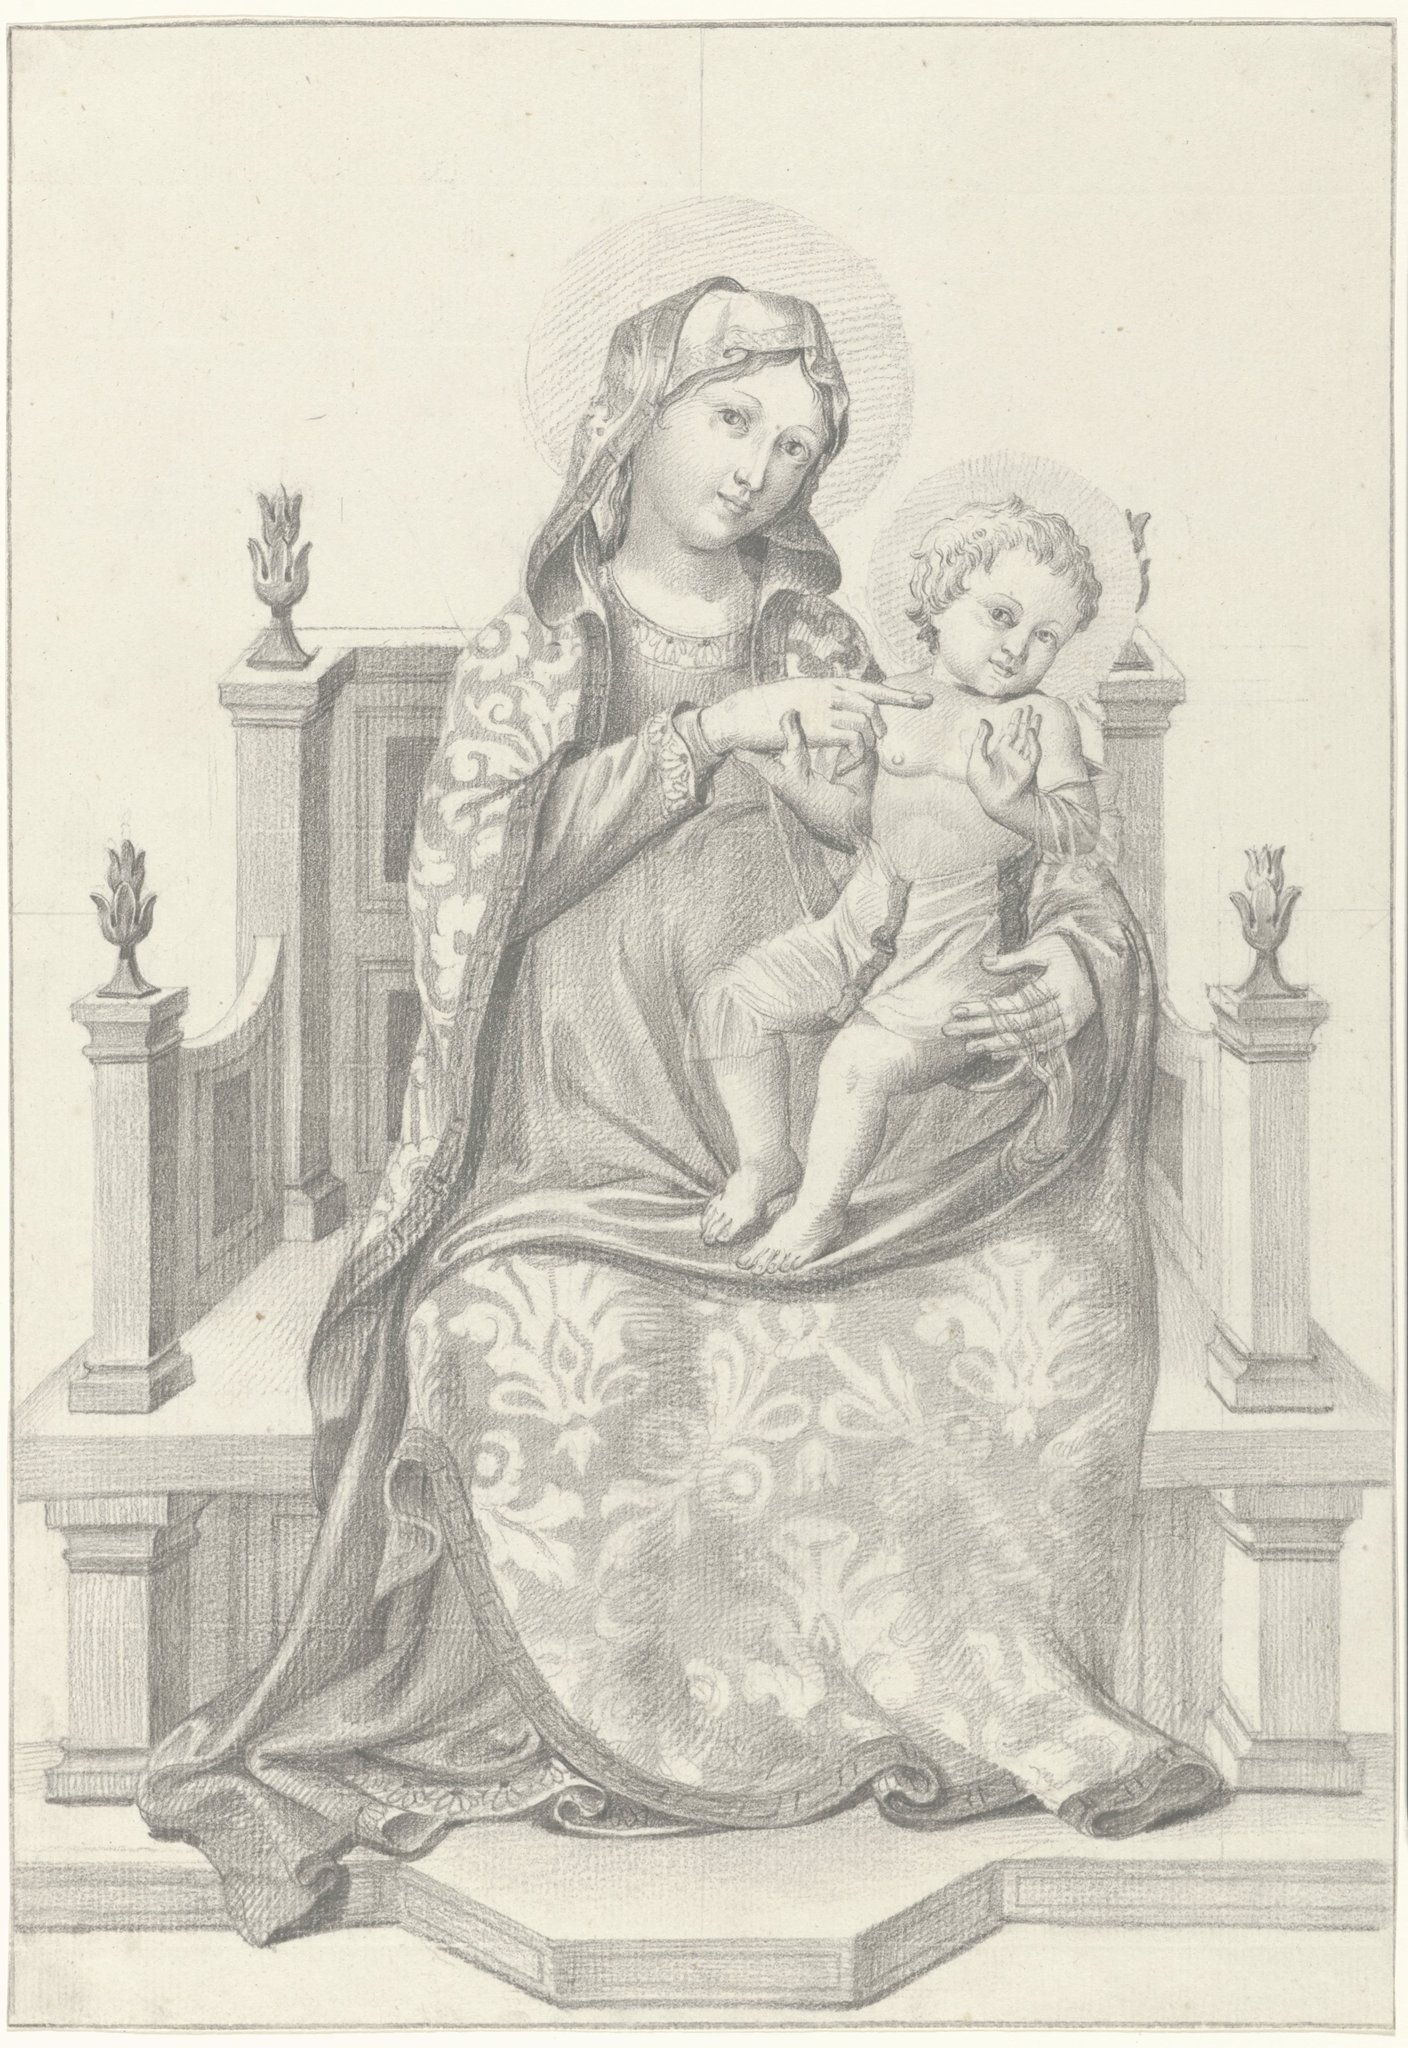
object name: drawing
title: Maria met Kind op troon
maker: Anonymous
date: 1778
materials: chalk, paper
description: Tekening uit het album 'Voyage en Italie, en Sicile et à Malte', 1778.